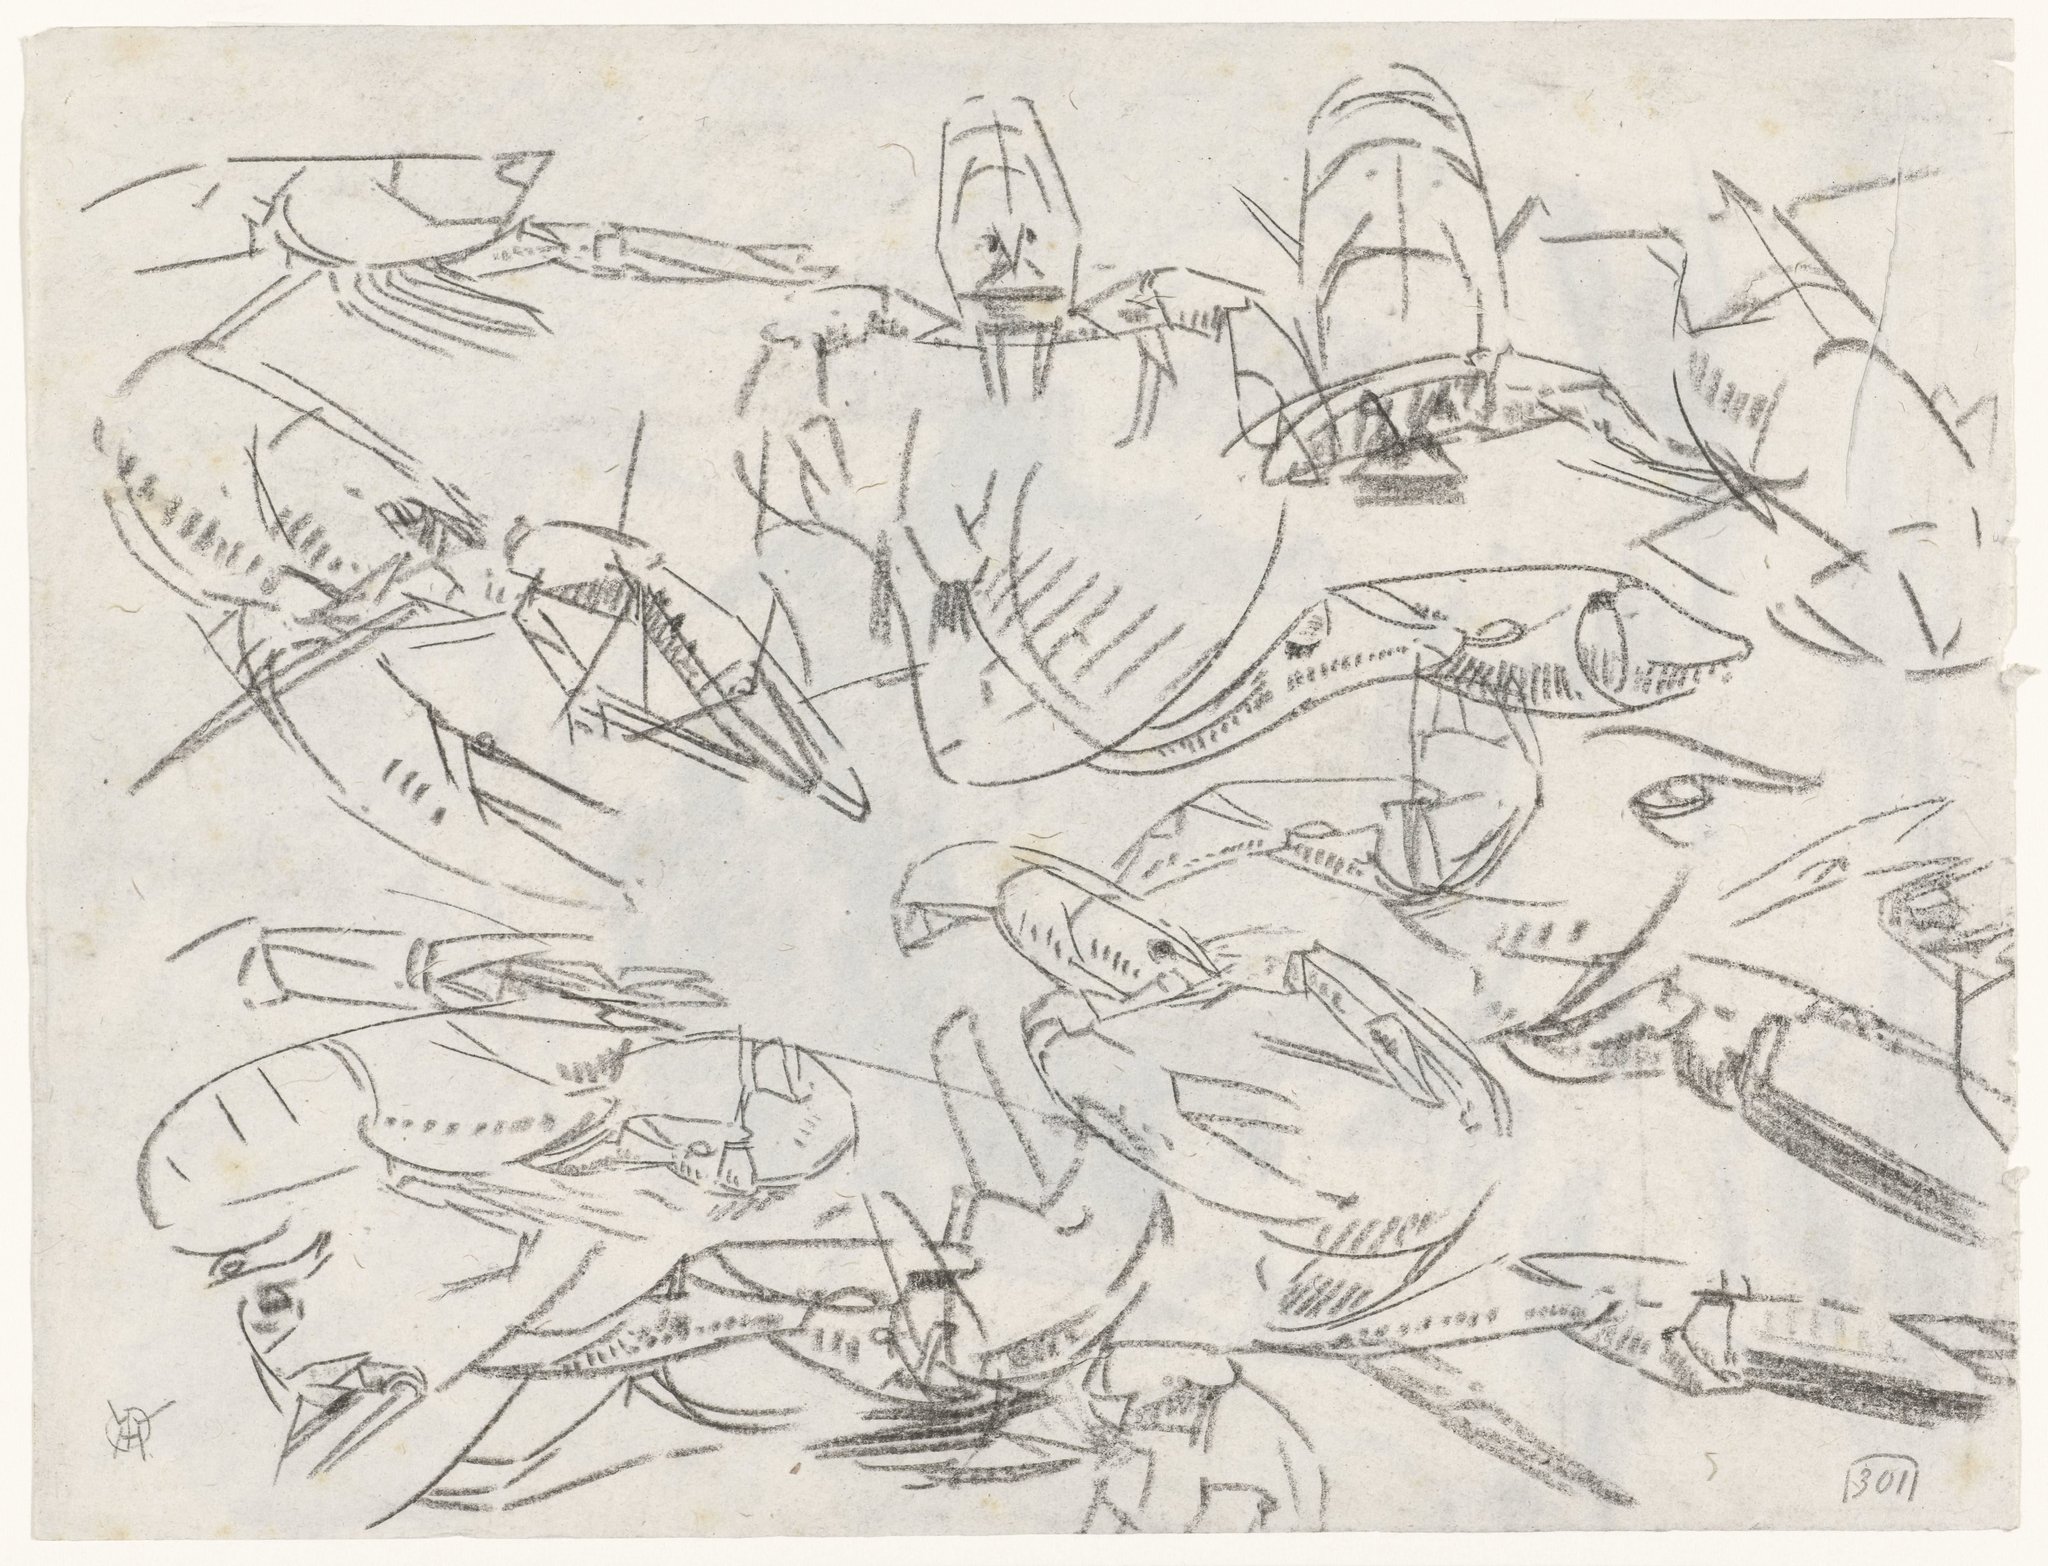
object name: drawing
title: Rotspoort in een aquarium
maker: gerrit willem dijsselhof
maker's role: designer, draughtsman, print maker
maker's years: 1866-1924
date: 1876-1924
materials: chalk, paper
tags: aquarium